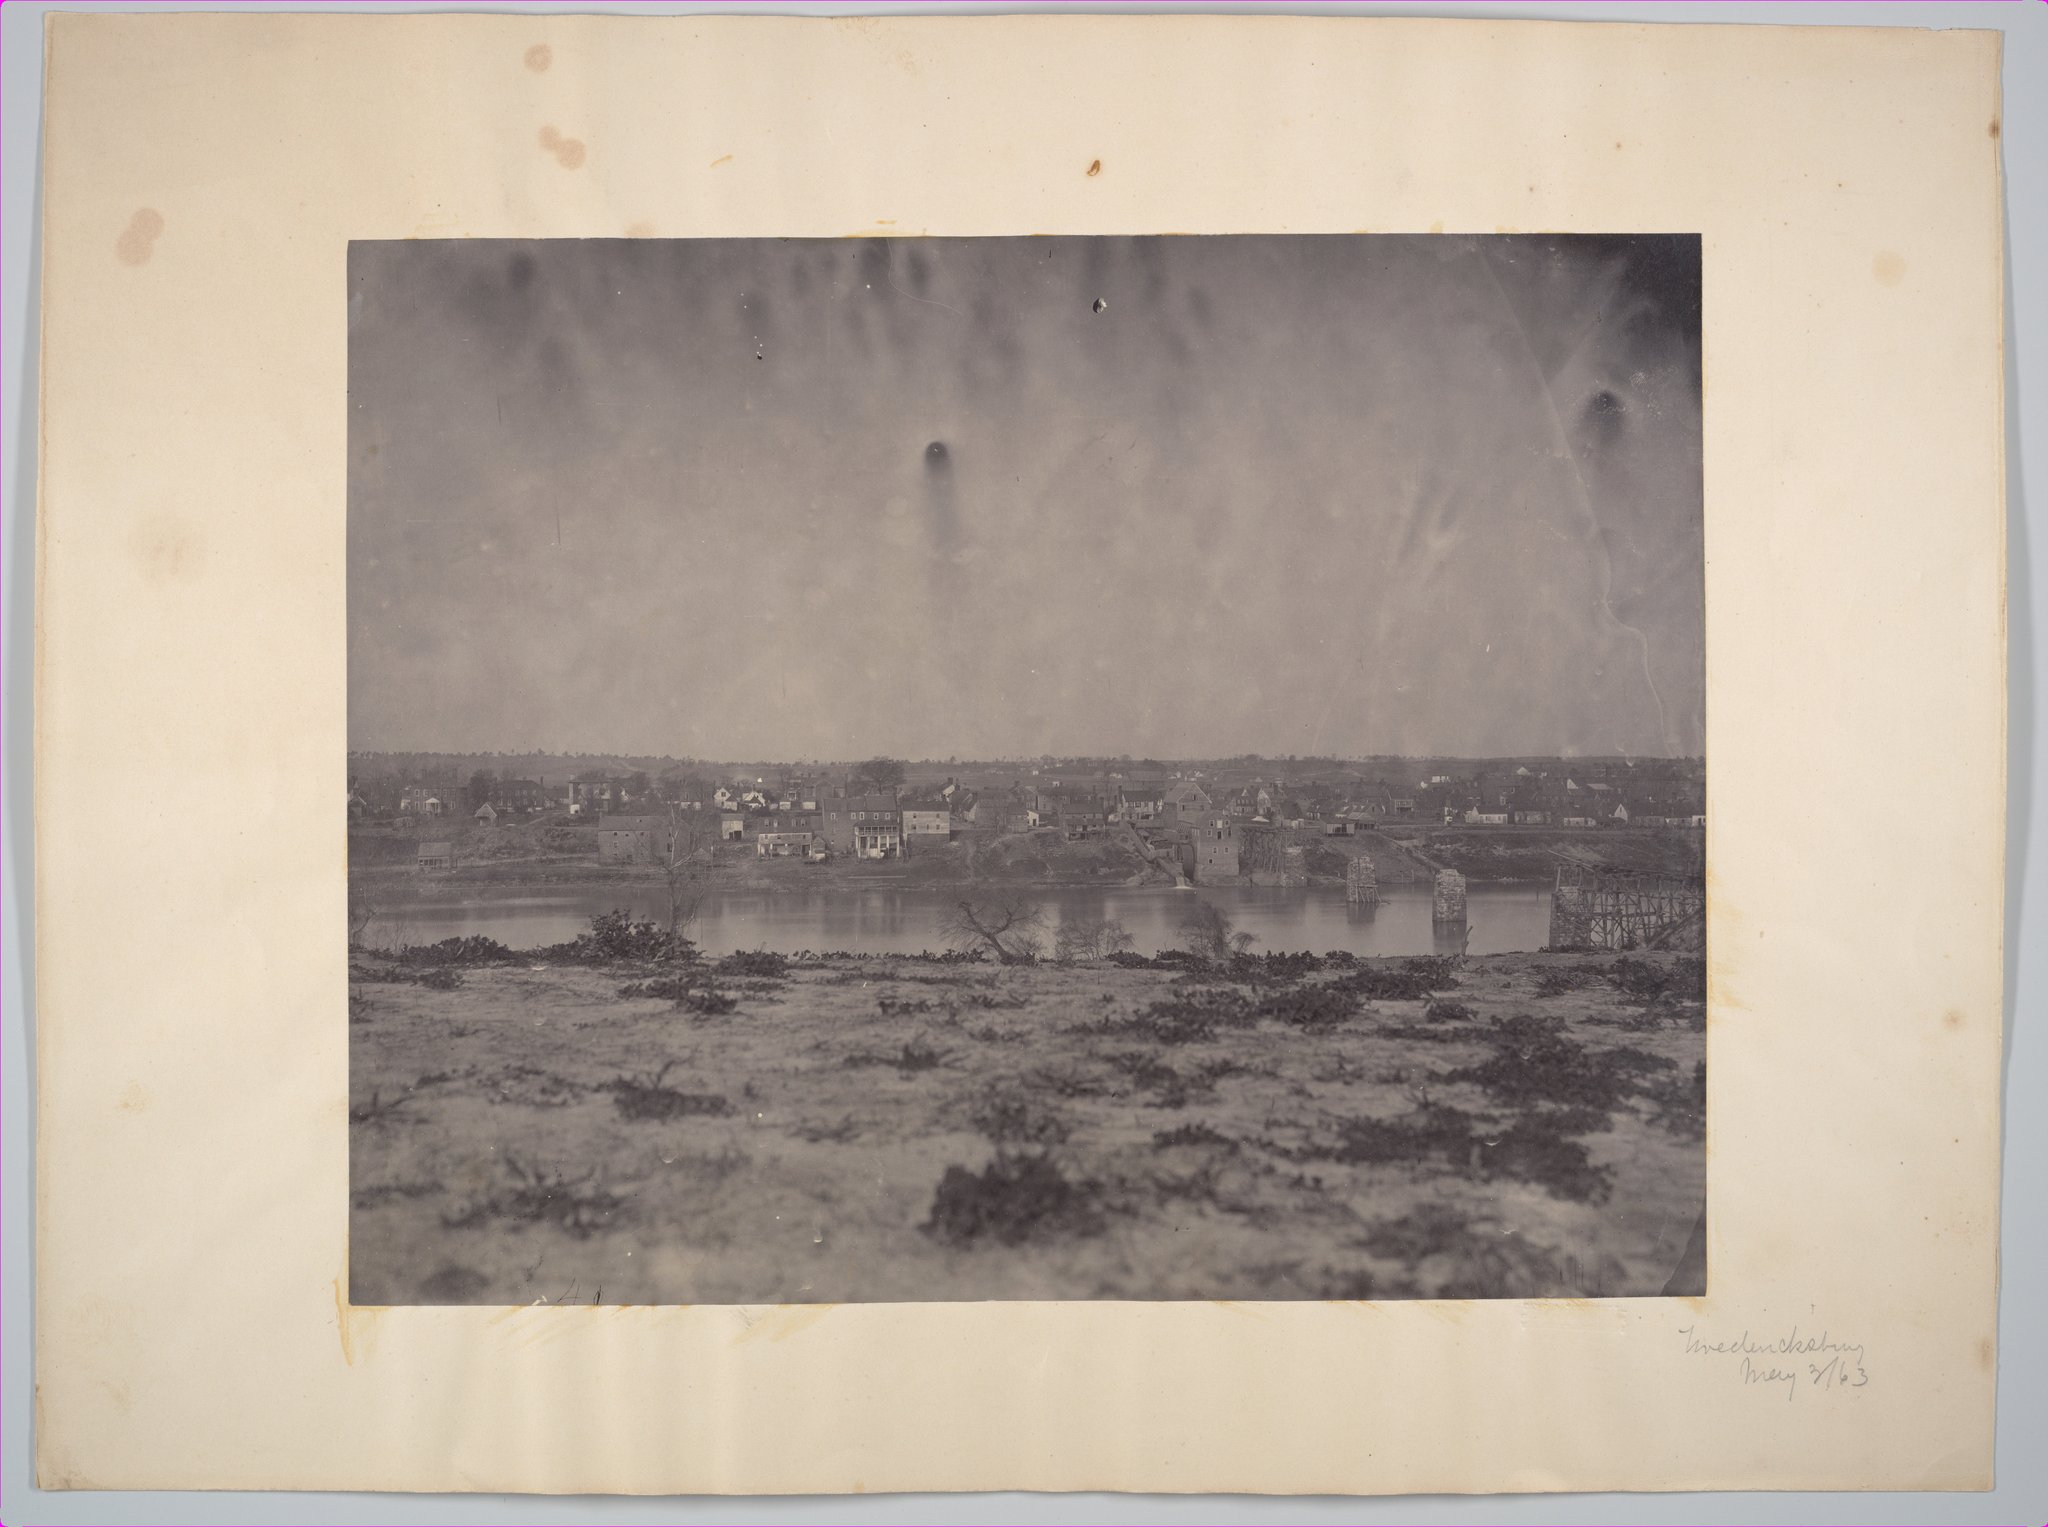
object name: photograph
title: Fredericksburgh, Maryland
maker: andrew joseph russell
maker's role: artist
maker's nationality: american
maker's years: 1830-1902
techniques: albumen silver print, glass negative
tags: american civil war